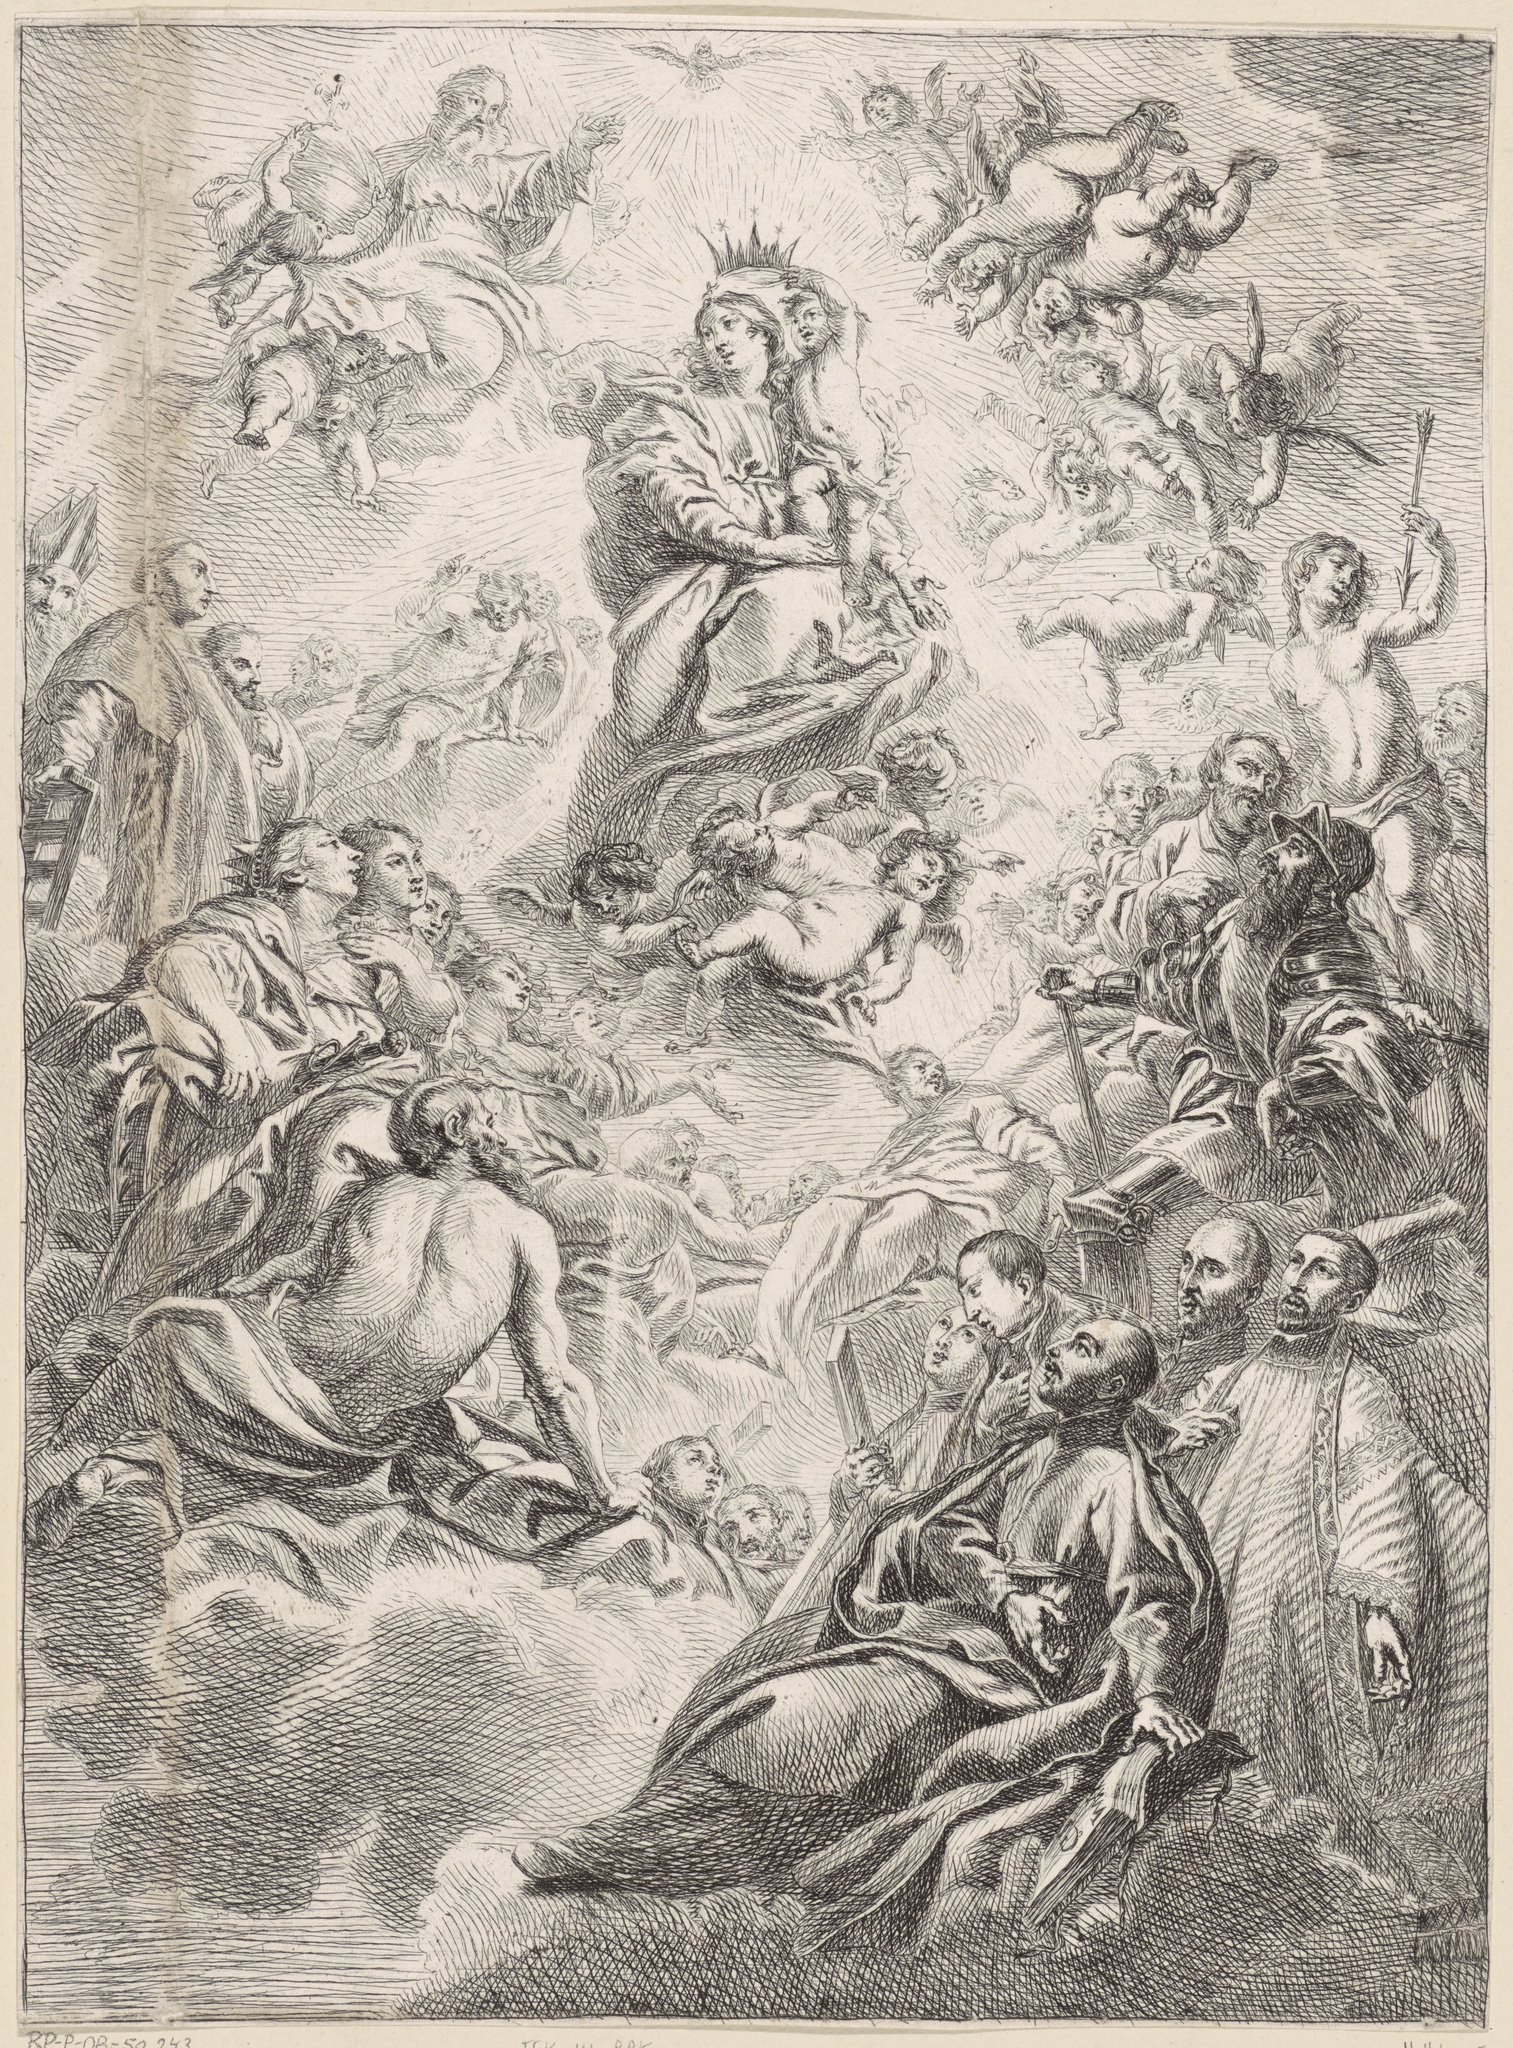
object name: print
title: Kroning van Maria door het Christuskind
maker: cornelis schut (i)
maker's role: draughtsman, print maker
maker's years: 1597-1655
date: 1618-1655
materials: paper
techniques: etching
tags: the christ-child crowning mary ~ madonna-representations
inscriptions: collector's mark: Lugt 240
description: Staand op haar schoot kroont het Christuskind zijn moeder. Boven haar hoofd de Heilige Geest (als duif). God de Vader maakt een zegenend gebaar. Naast hem draagt een putto een globe. Putti dartelen rond in de lucht, terwijl een grote groep heiligen omhoog kijkt naar de kroning.